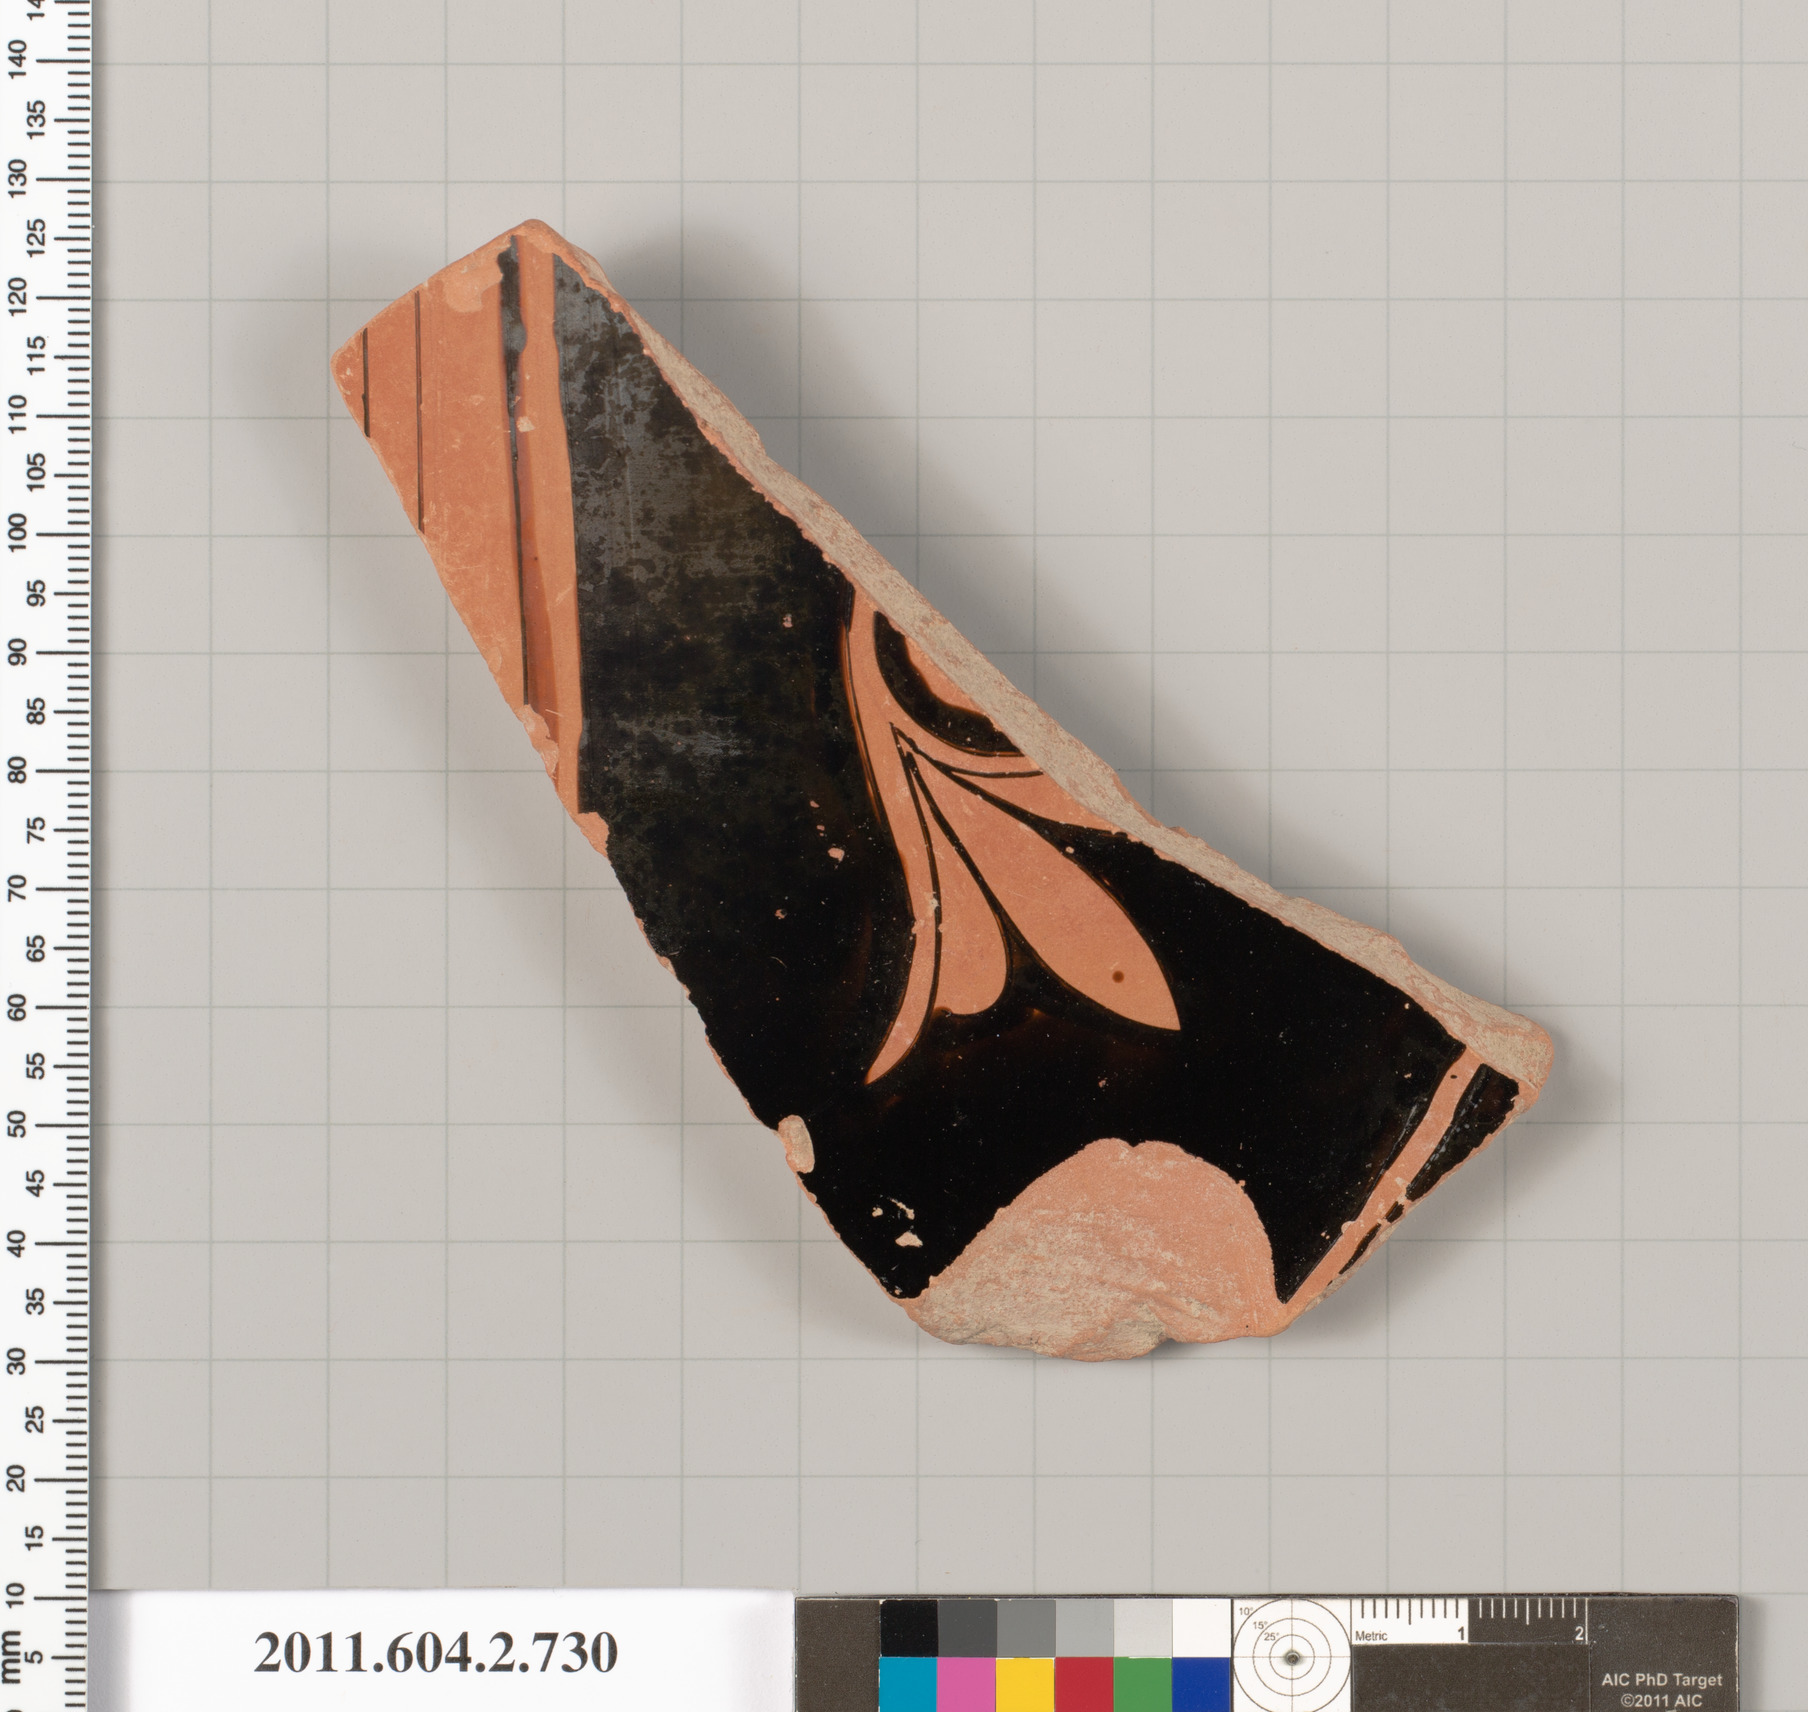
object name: calyx krater fragment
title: Terracotta fragment of a calyx-krater (bowl for mixing wine and water)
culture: greek, attic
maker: altamura painter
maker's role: artist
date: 470-460 BCE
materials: terracotta